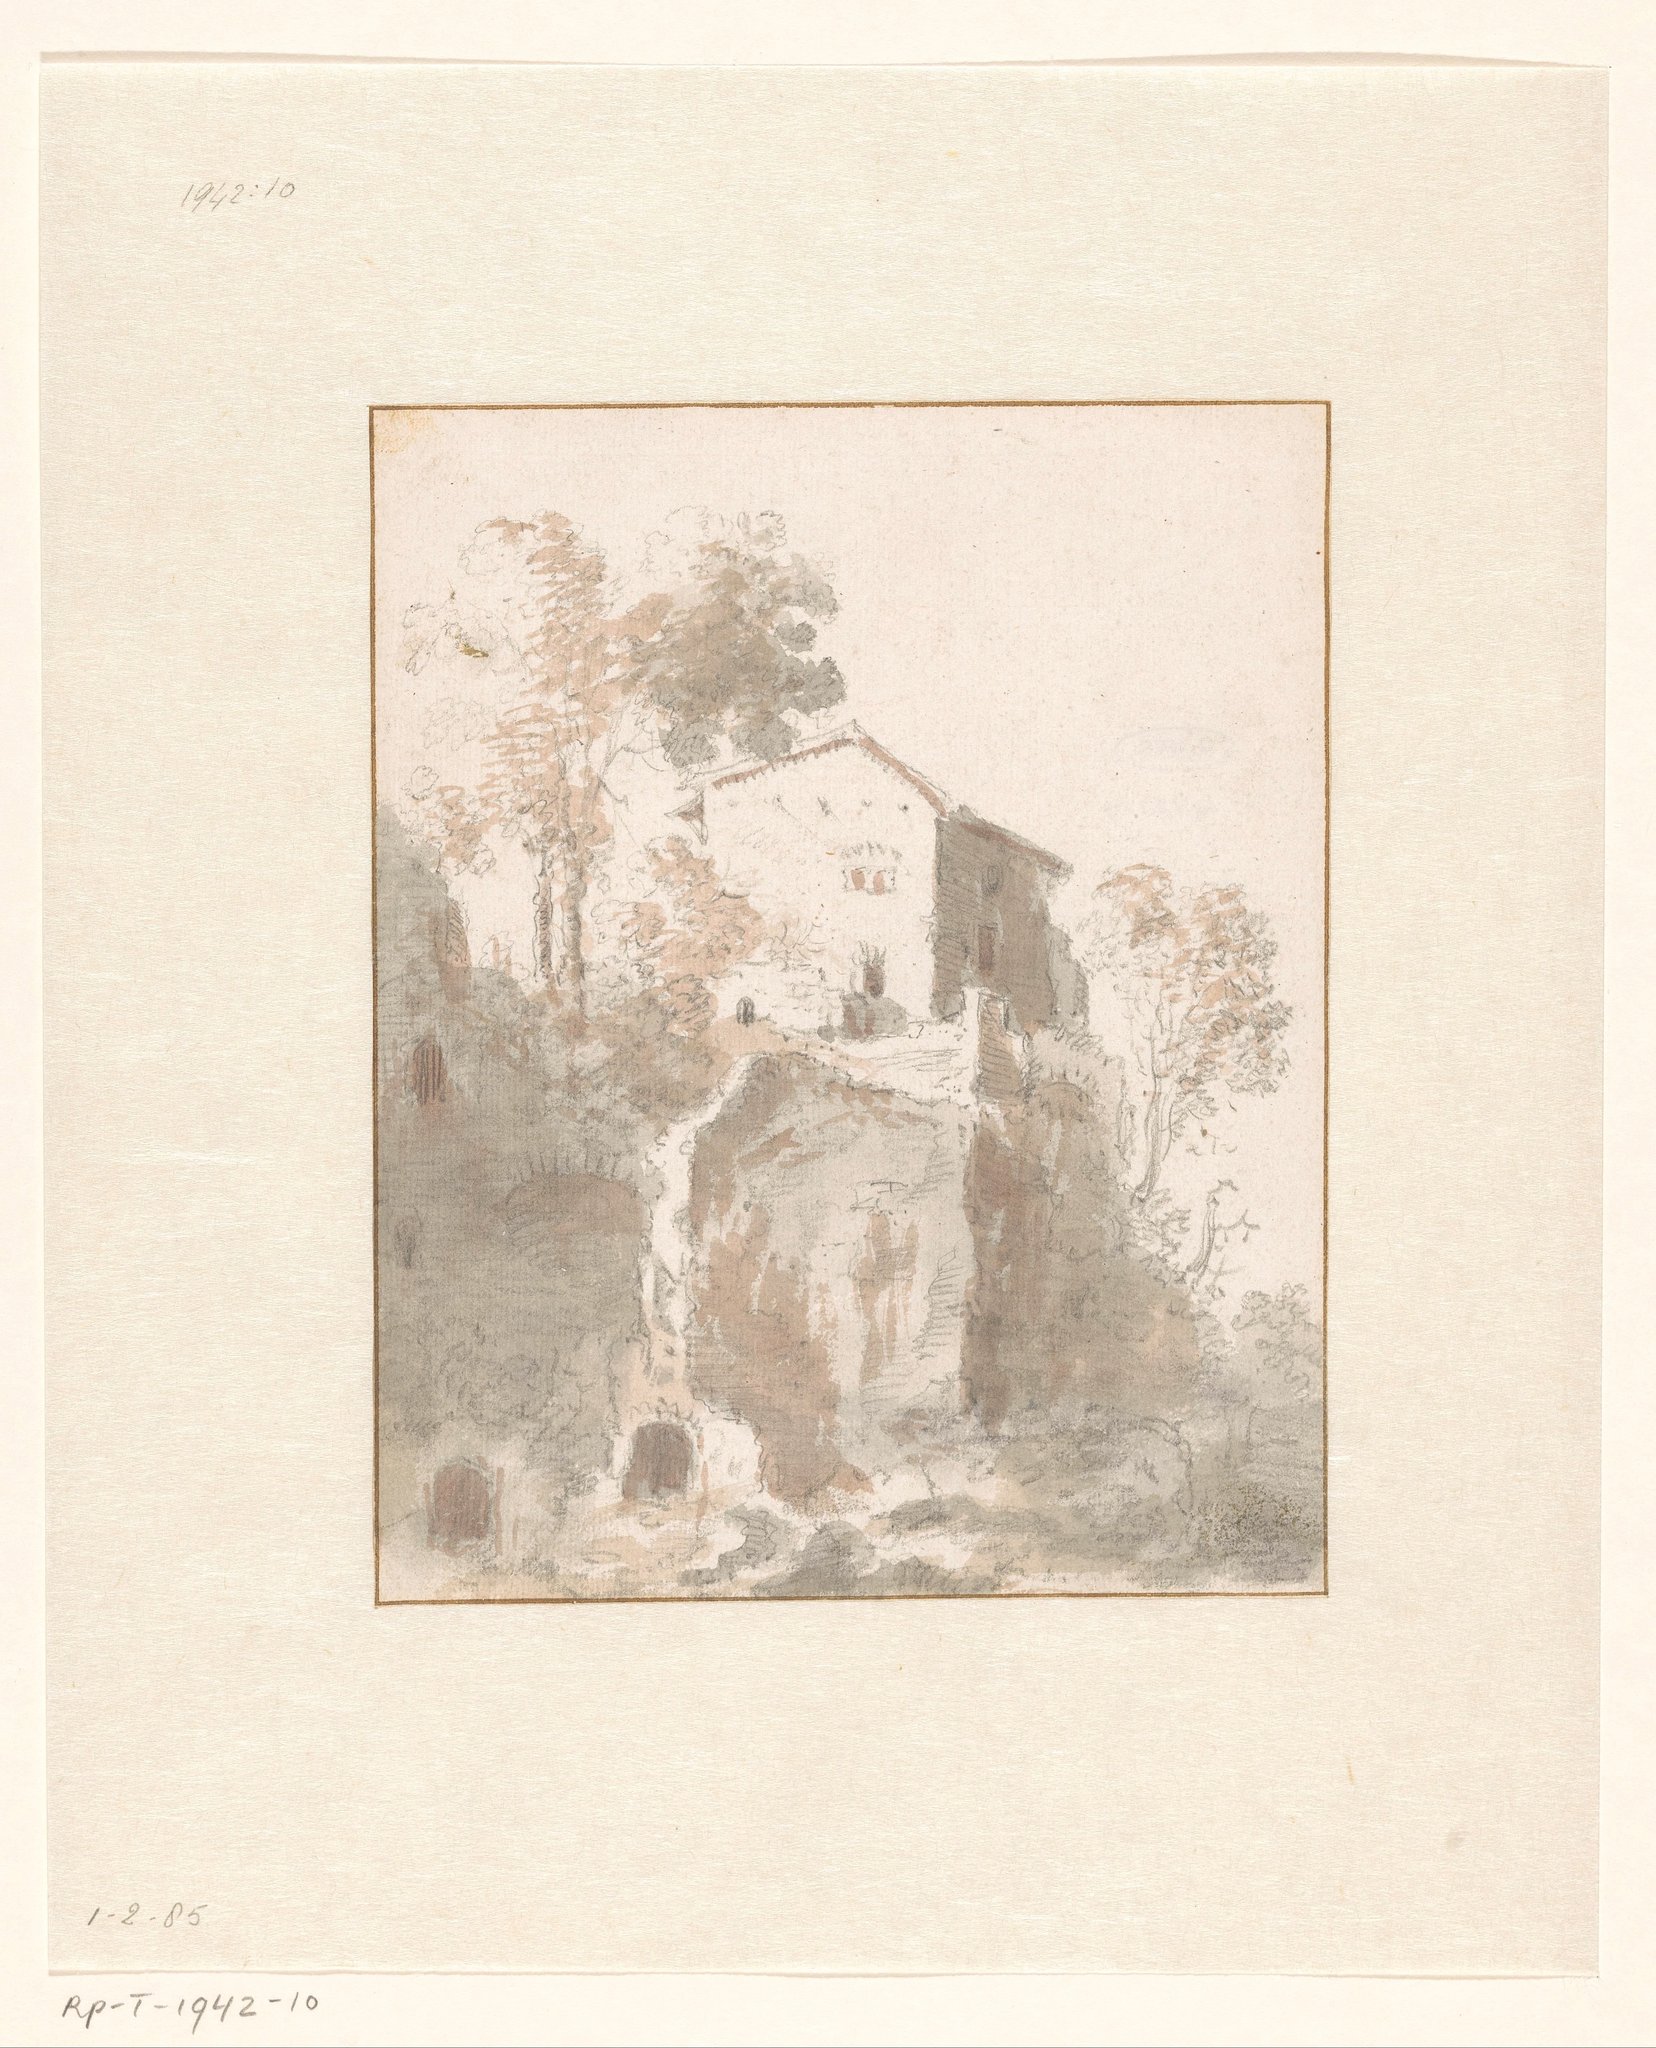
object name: drawing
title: Rotsachtig landschap met een huis en bomen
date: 1600-1699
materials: chalk, paper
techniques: brush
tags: city-view, and landscape with man-made constructions, rural housing, e.g. country-house, villa, cottage